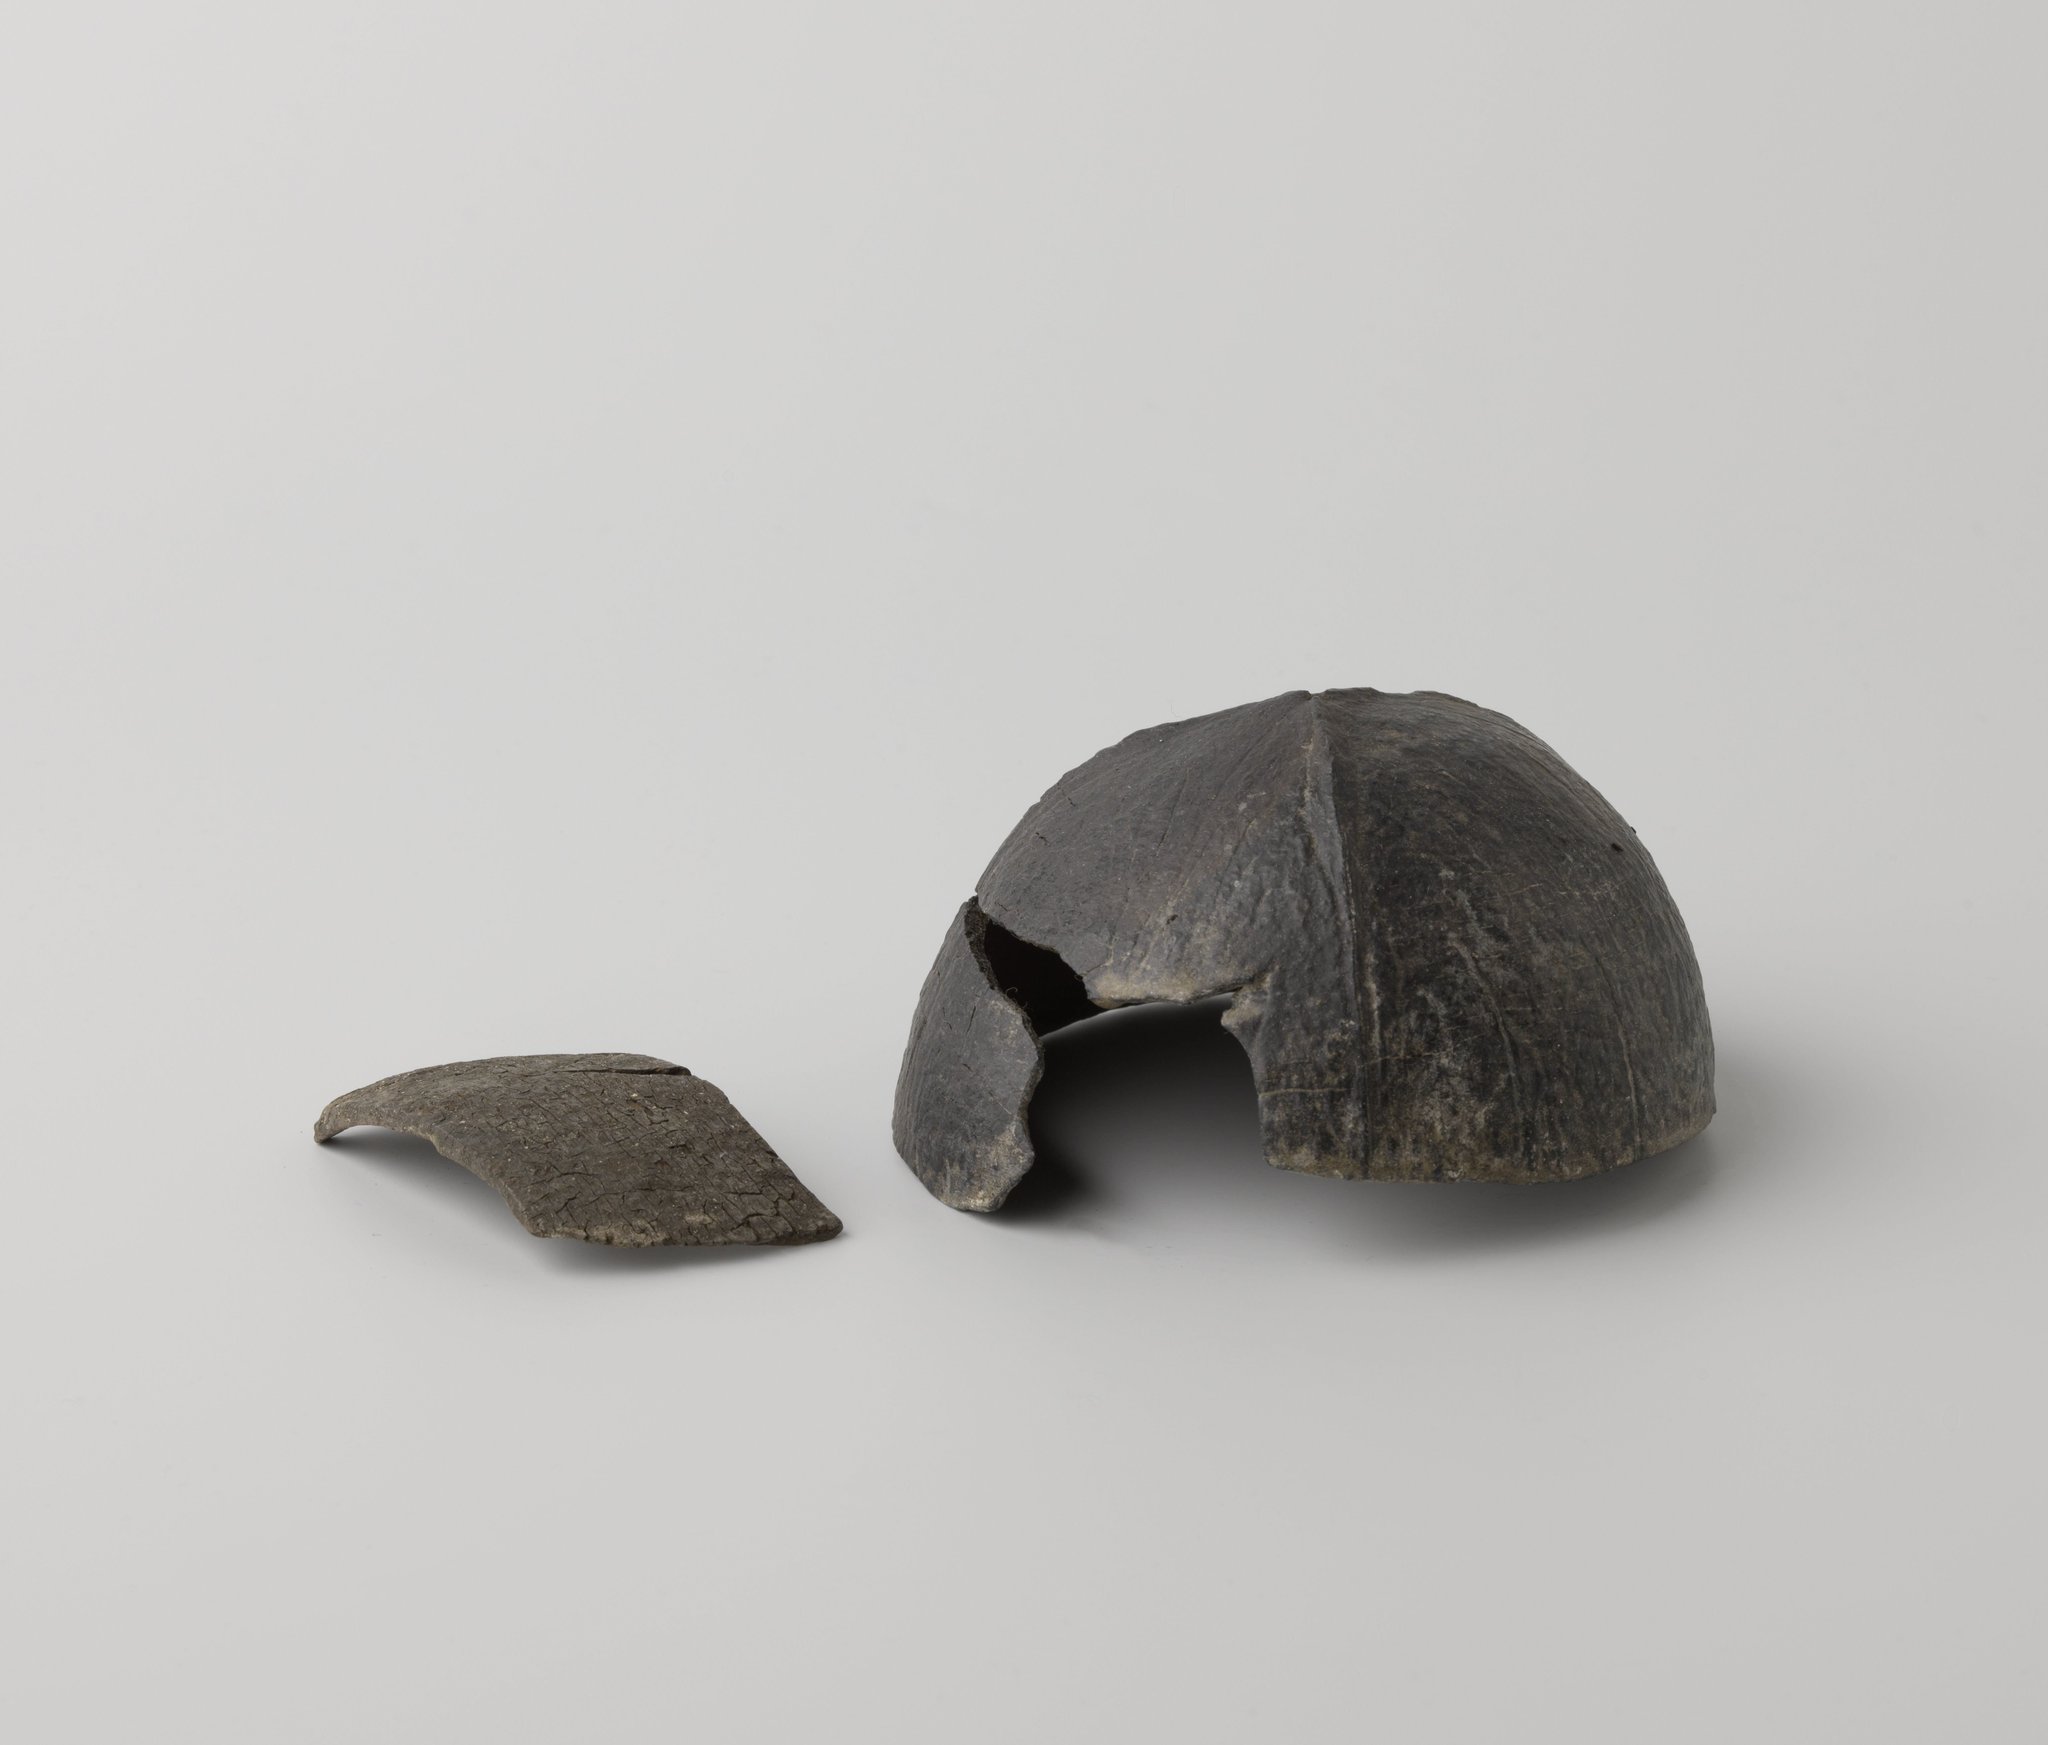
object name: coconut fruit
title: Twee delen van kokosnoot uit V.O.C.-schip de 'Witte Leeuw'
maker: Anonymous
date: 1613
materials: plant material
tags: verenigde oostindische compagnie, sint-helena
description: Twee delen van kokosnoot uit V.O.C.-schip de 'Witte Leeuw'. Grofweg de helft, de bovenzijde, en een stuk uit de wand.